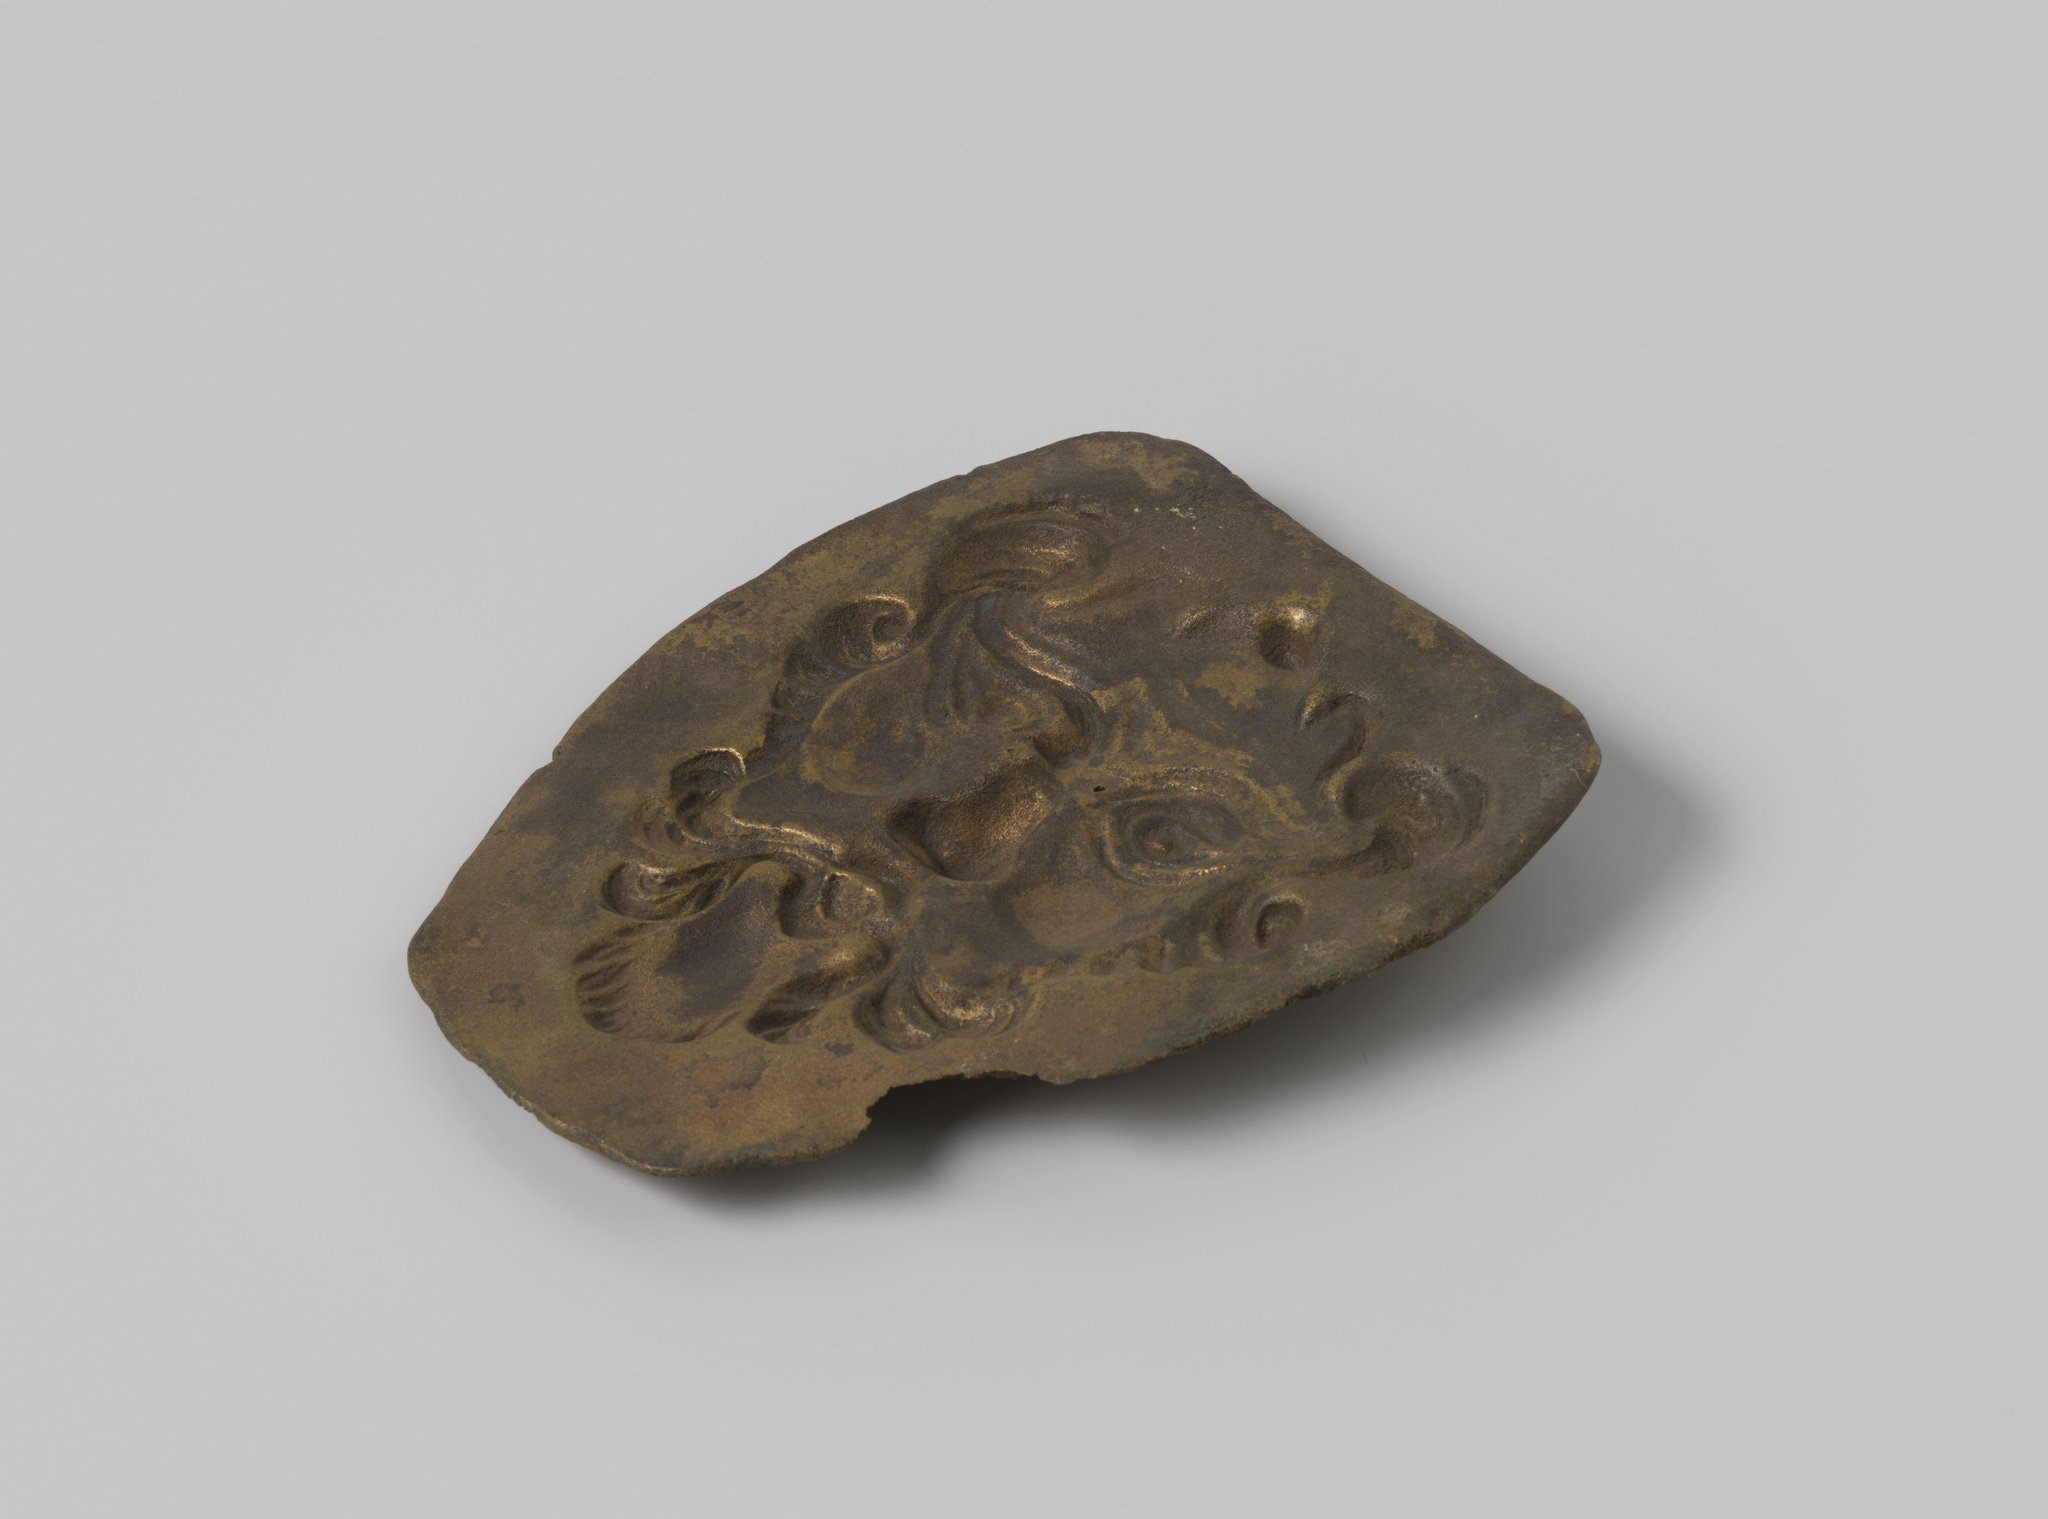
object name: mould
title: Mal uit het wrak van de Oost-Indiëvaarder Hollandia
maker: Anonymous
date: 1700-1743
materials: copper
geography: netherlands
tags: batavia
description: Mal van brons, in de vorm van een leeuwenkop. Mogelijk bestemd voor het vervaardigen van loden tuinornamenten in parken en tuinen rondom Batavia.